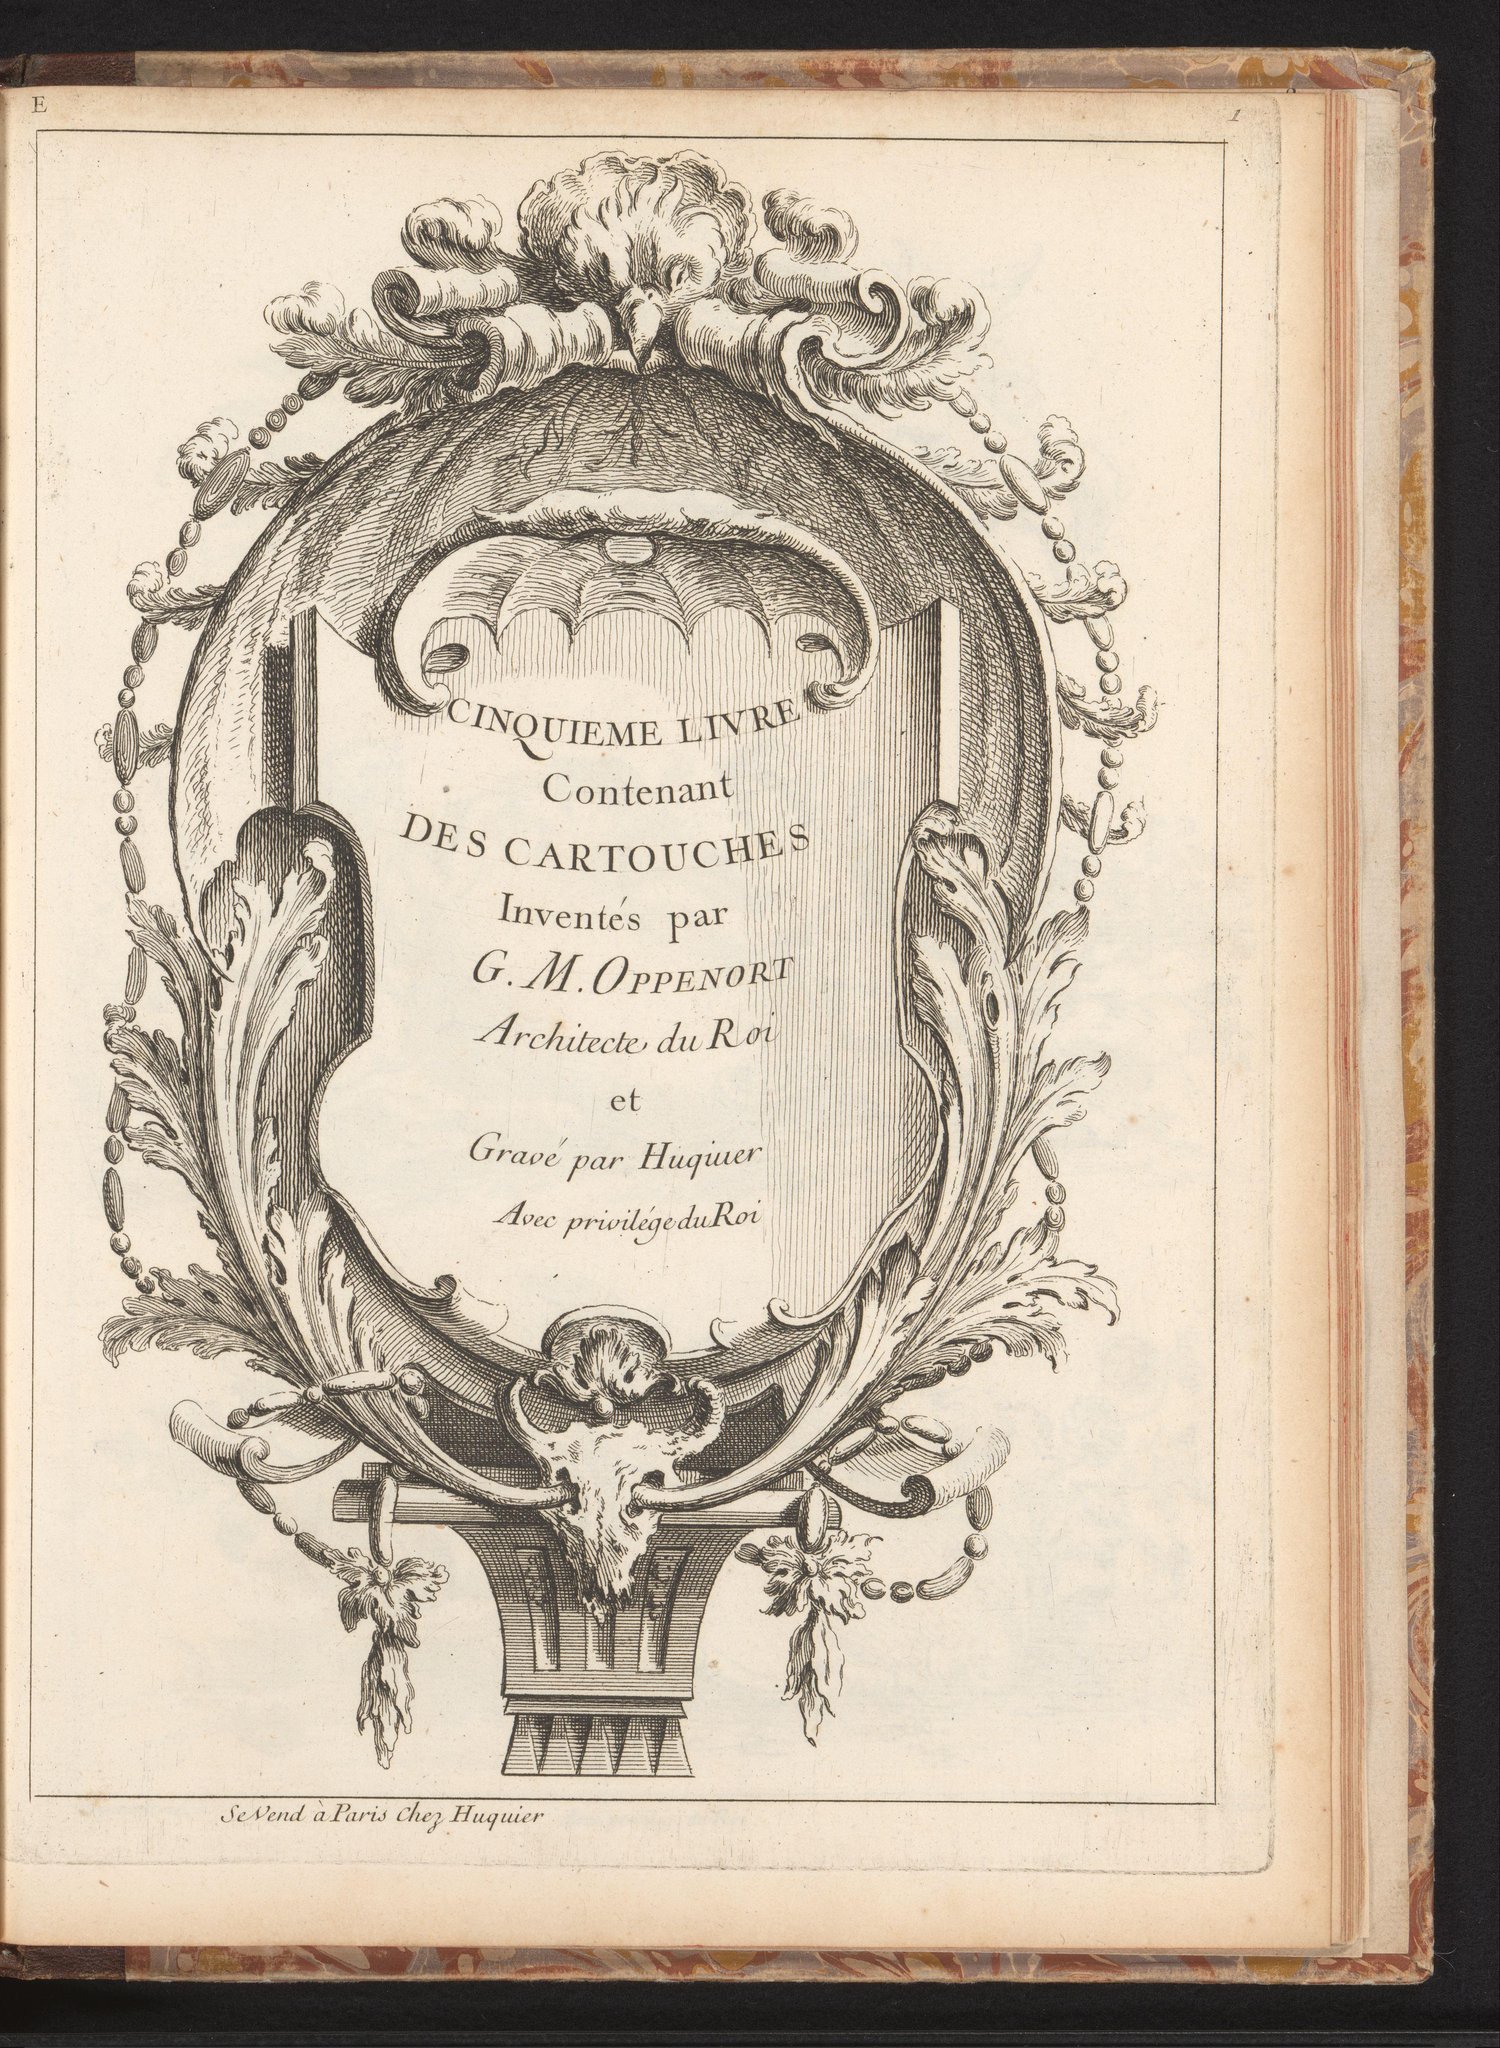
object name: titelprent, frontispice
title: Titelprent voor een serie ontwerpen van cartouches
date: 1725-1750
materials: paper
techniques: etching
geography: paris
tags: ornaments ~ art, title-page, ornament ~ cartouche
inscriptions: collector's mark: Lugt 2228a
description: Deze prent maakt deel uit van een album.